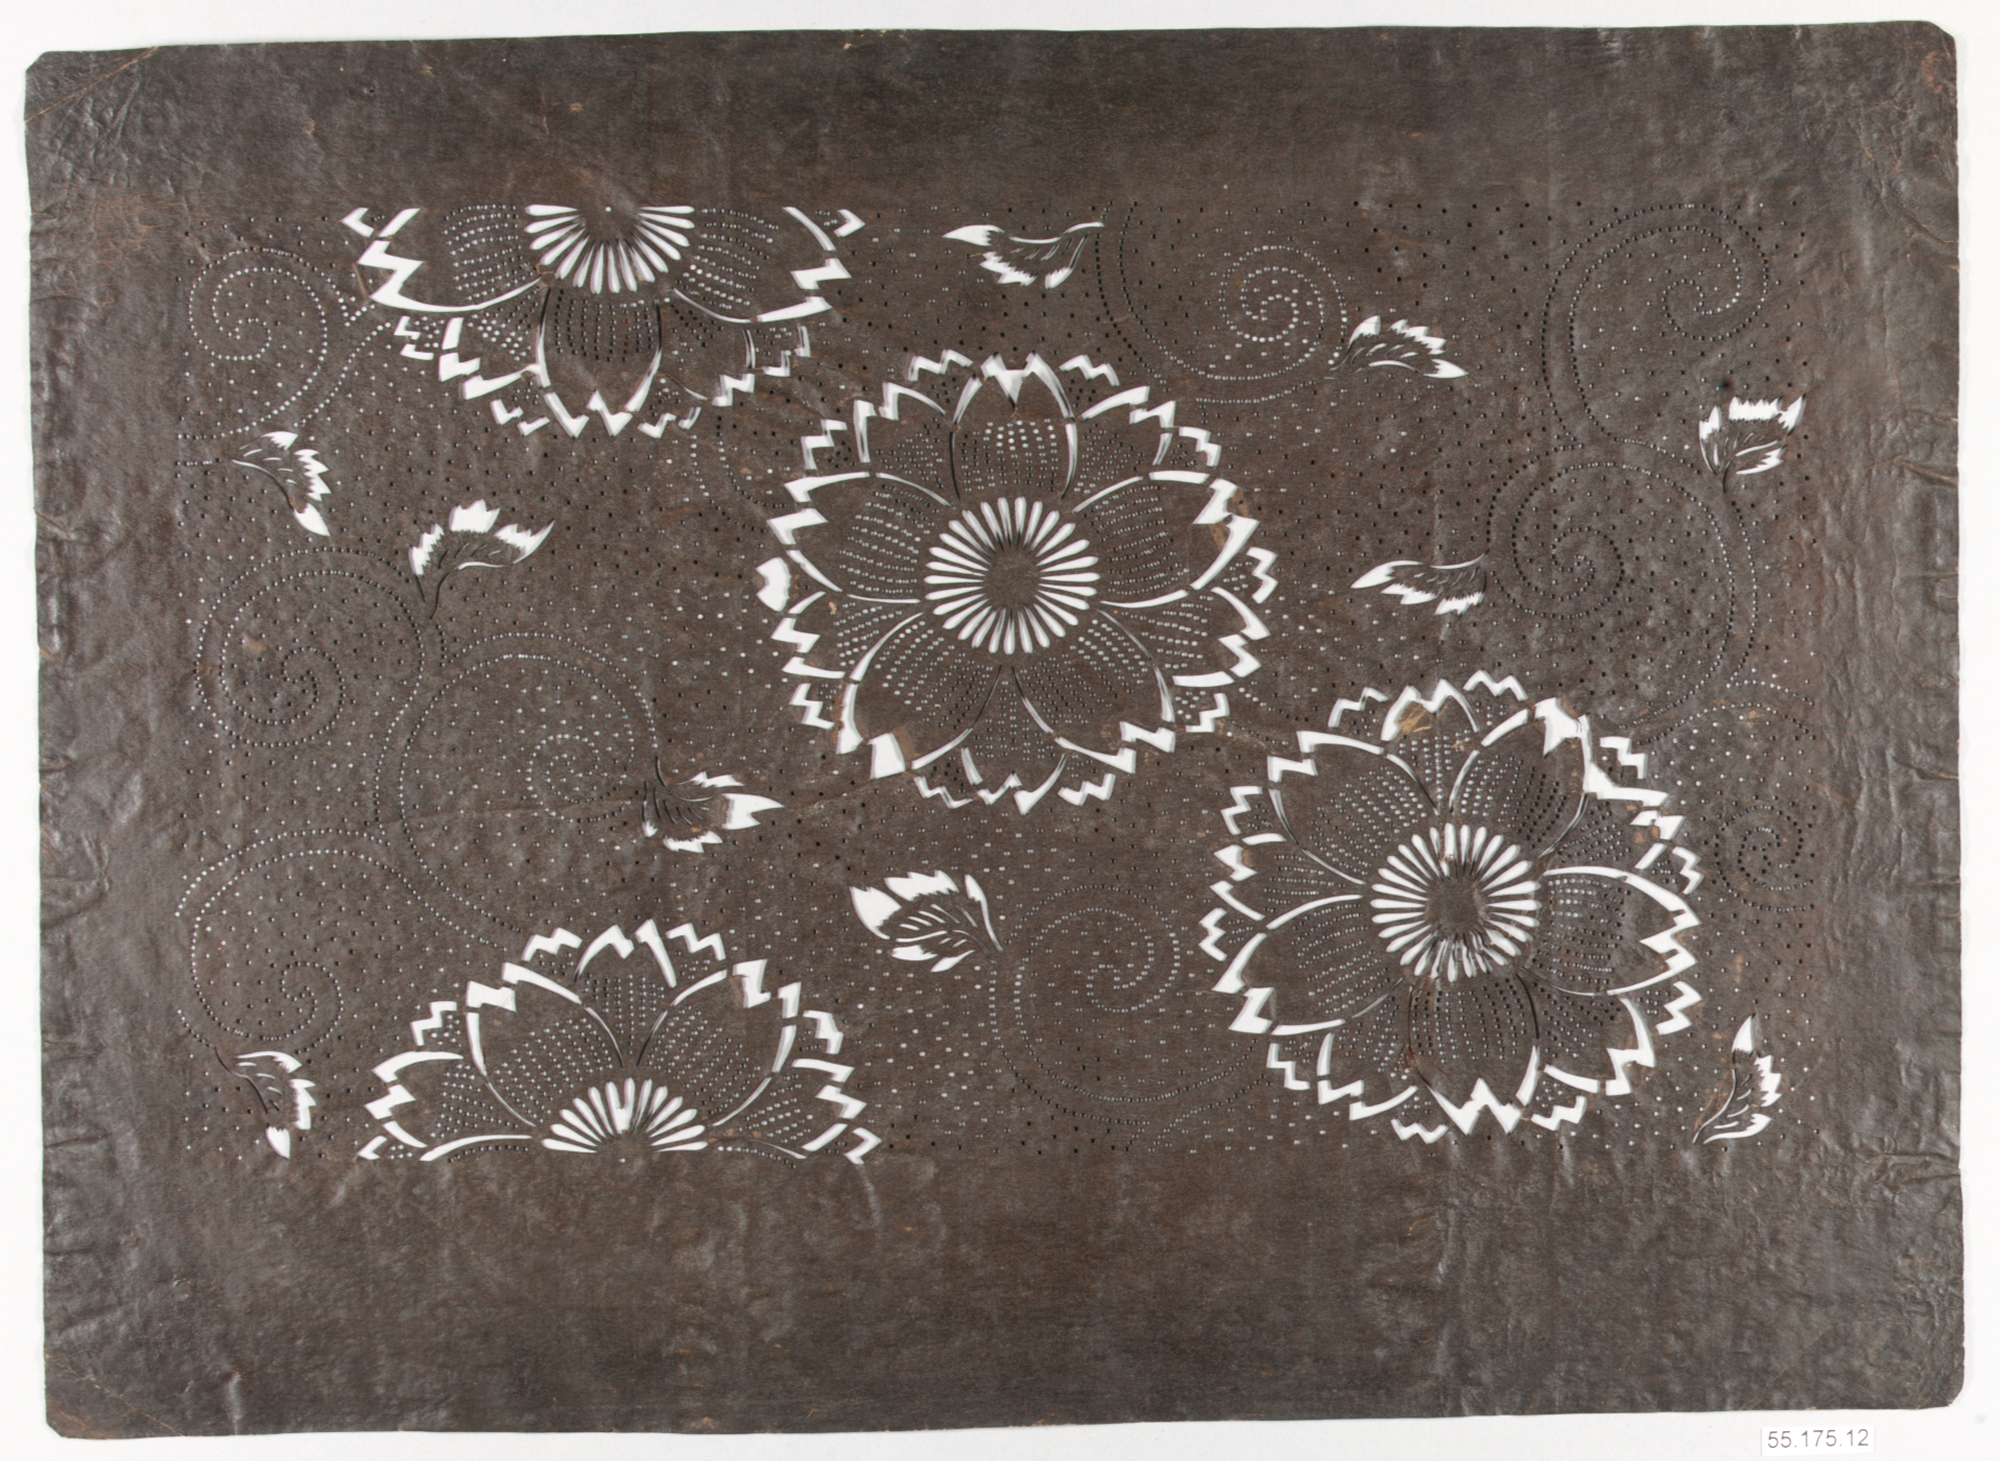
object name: stencil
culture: japanese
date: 1801-1900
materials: paper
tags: flowers